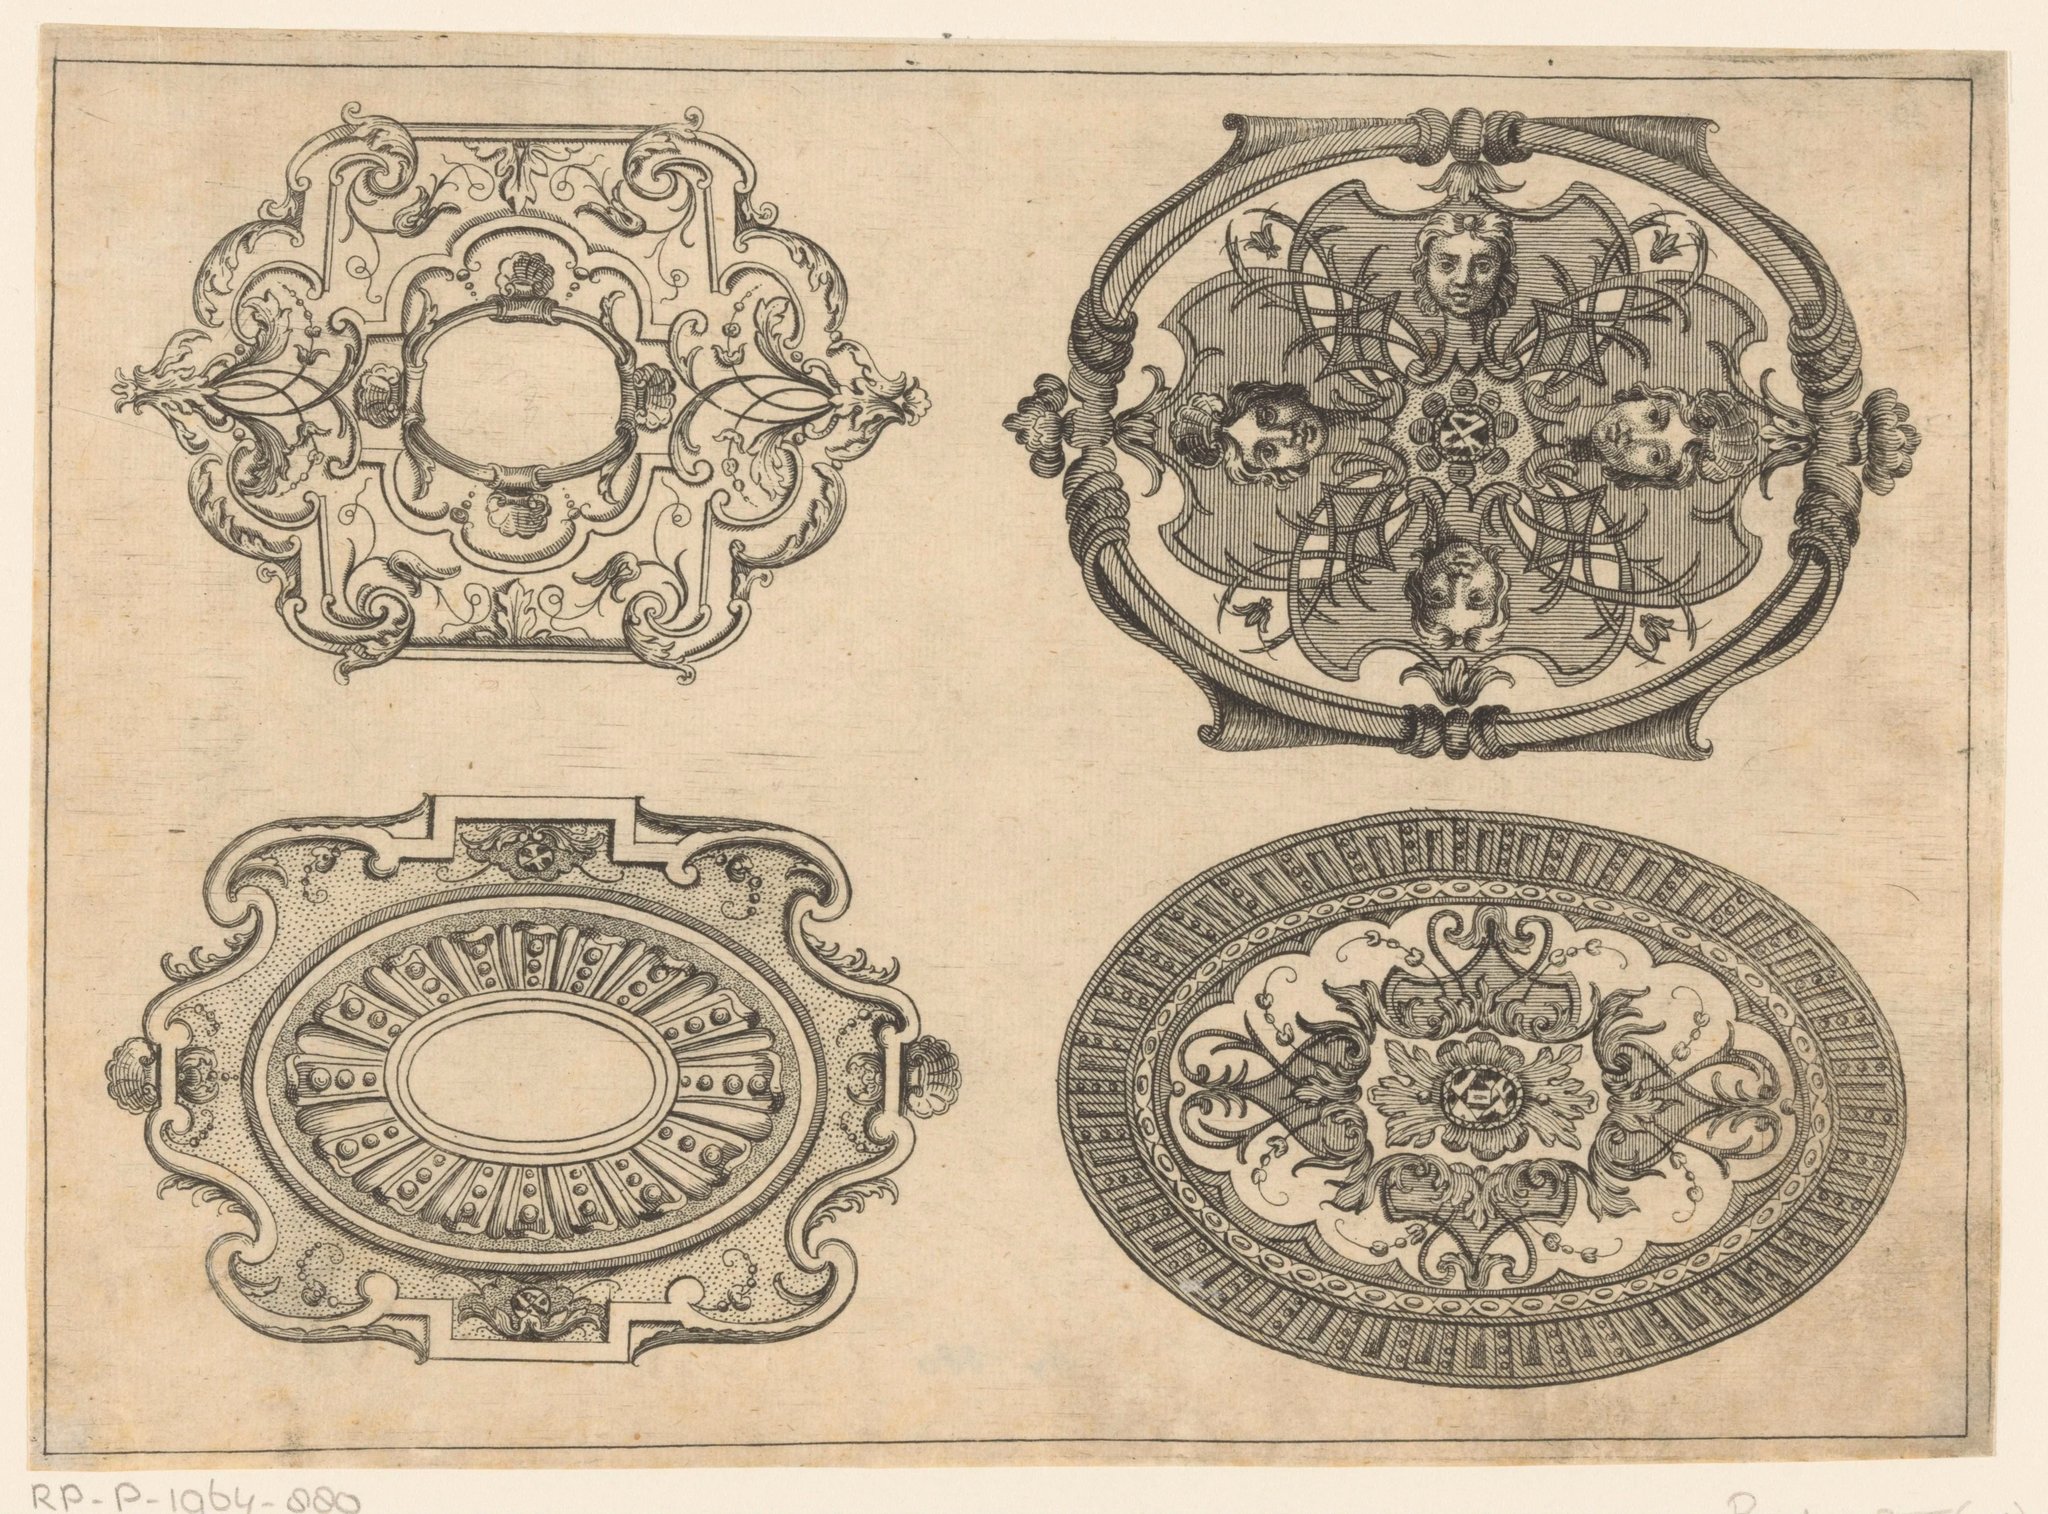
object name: print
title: Geornamenteerde deksels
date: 1670-1725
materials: paper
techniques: etching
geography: germany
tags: ornaments ~ art, snuff-box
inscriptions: collector's mark: Lugt 2760, collector's mark: Lugt 2228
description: Vier deksels van snuifdozen. Links boven en links- en rechts onder met ornamenten. Rechts boven met maskers.